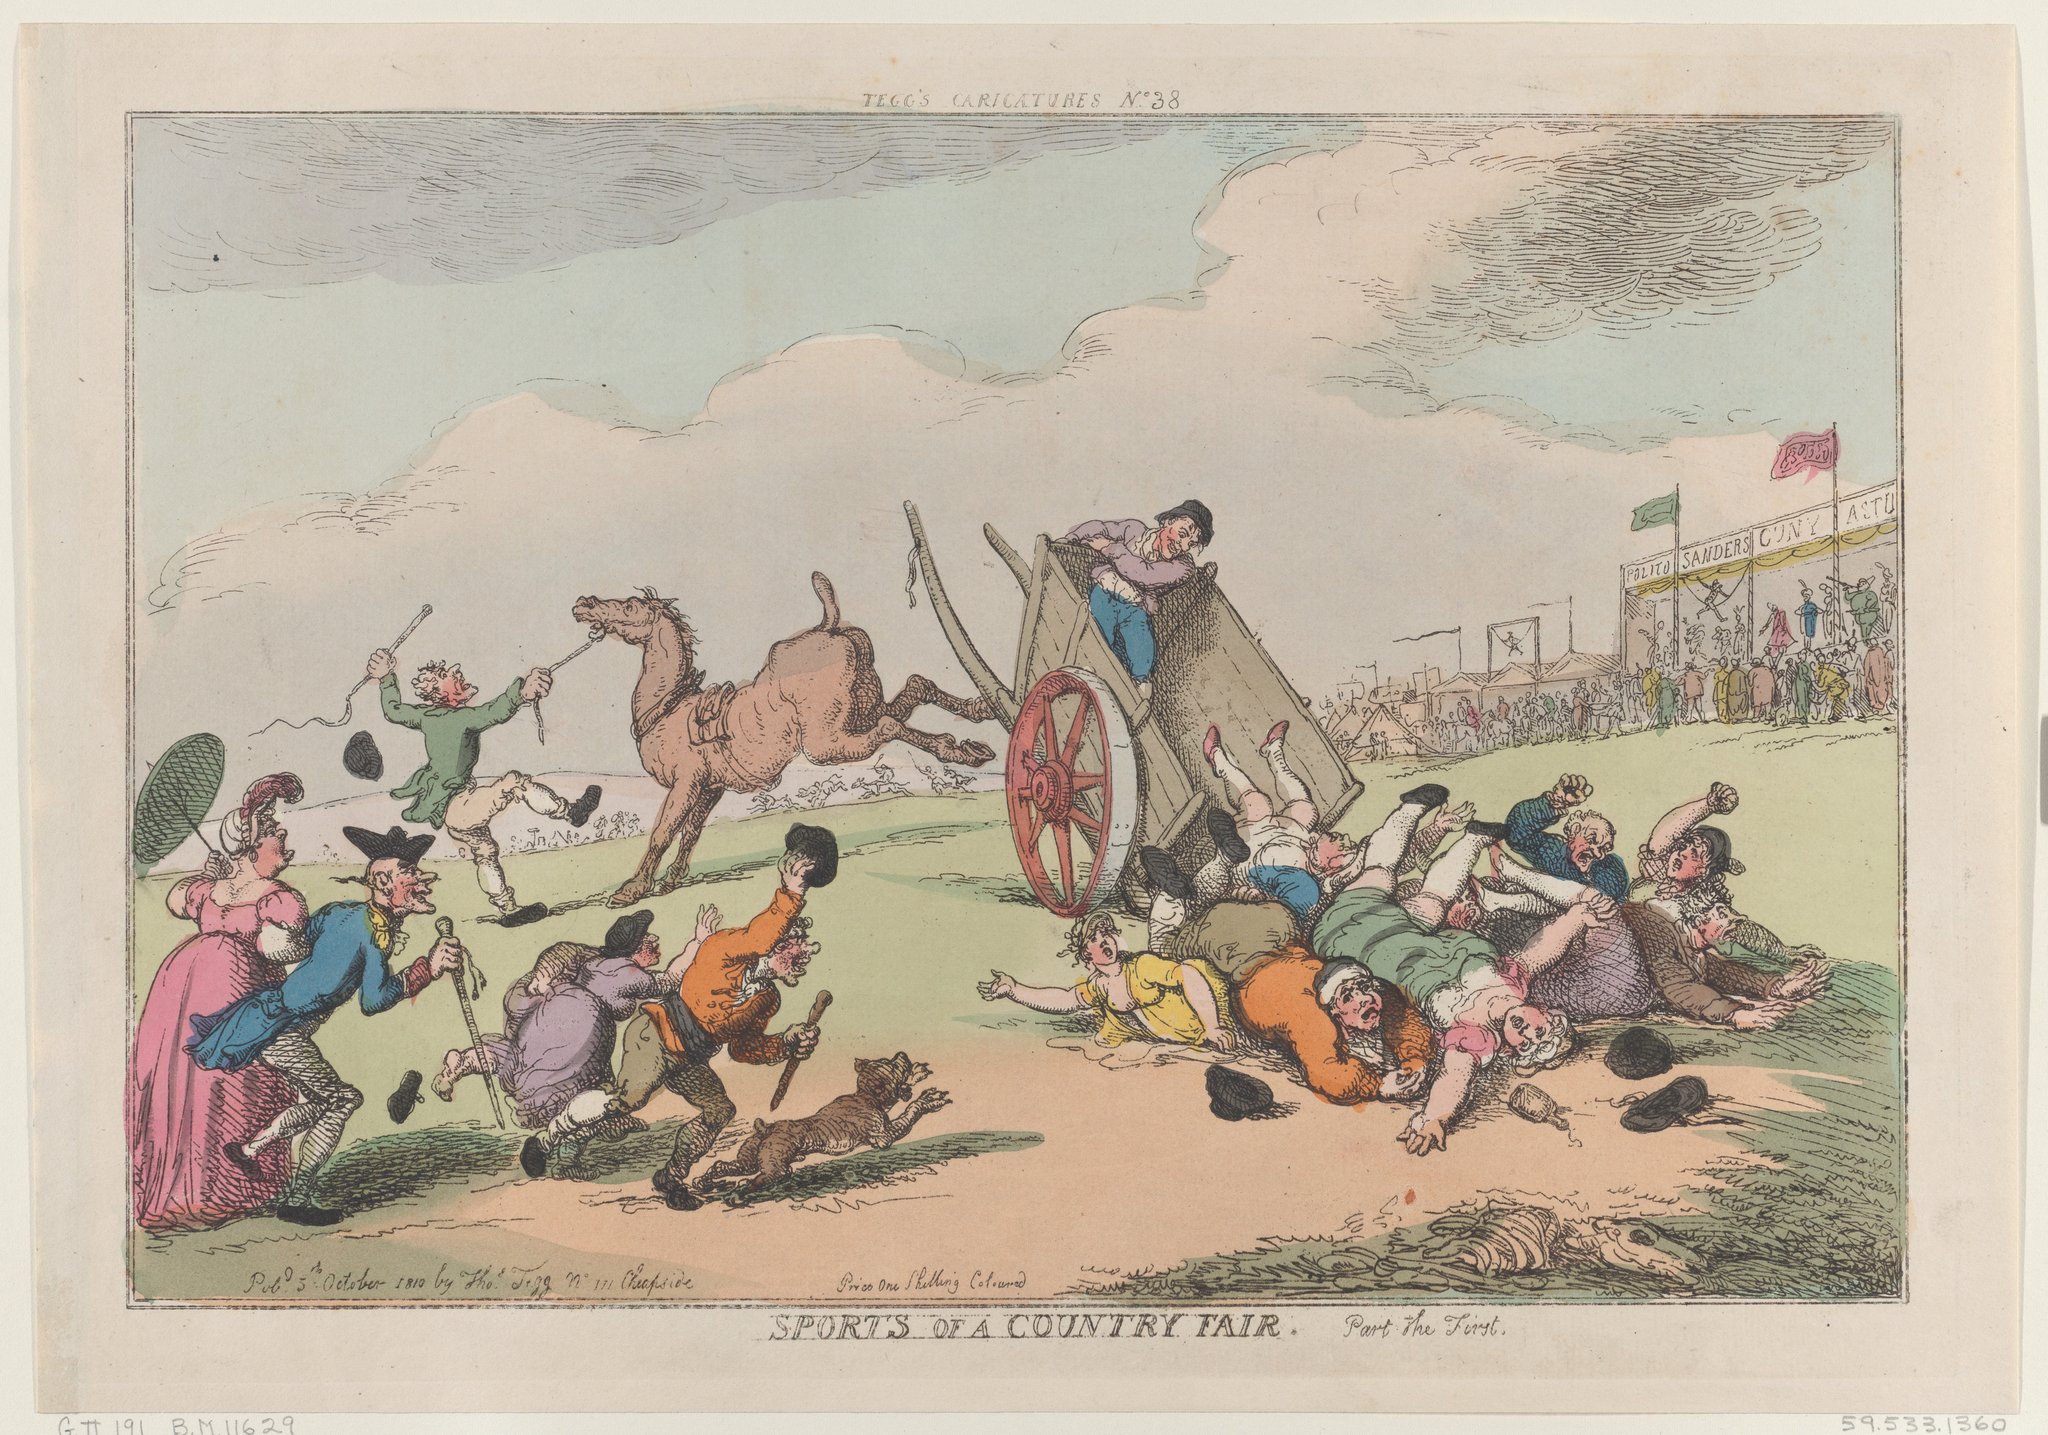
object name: print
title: Sports of a Country Fair, Part the First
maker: thomas rowlandson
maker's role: artist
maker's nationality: british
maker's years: 1757-1827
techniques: etching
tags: satire,men,women,horses,carts